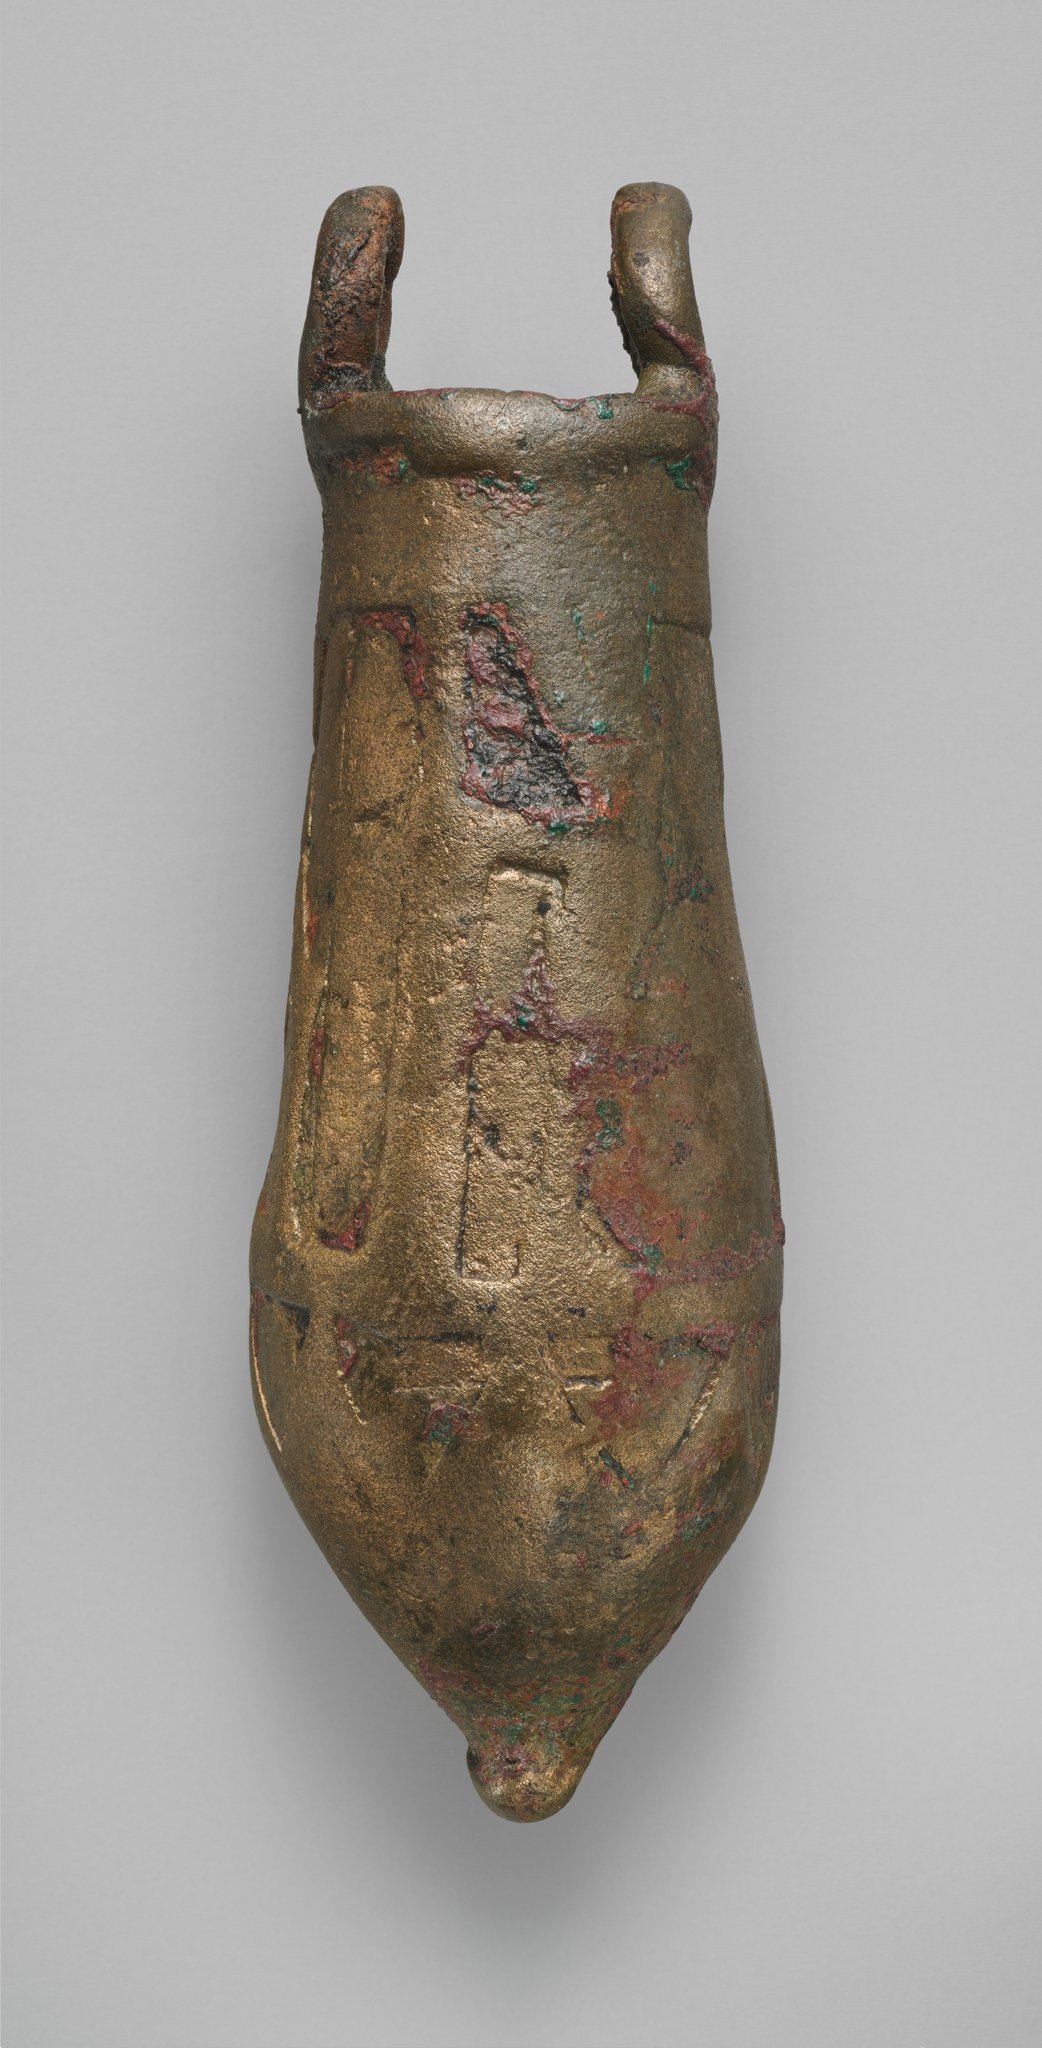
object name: situla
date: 600 BCE-100 CE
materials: copper alloy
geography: egypt